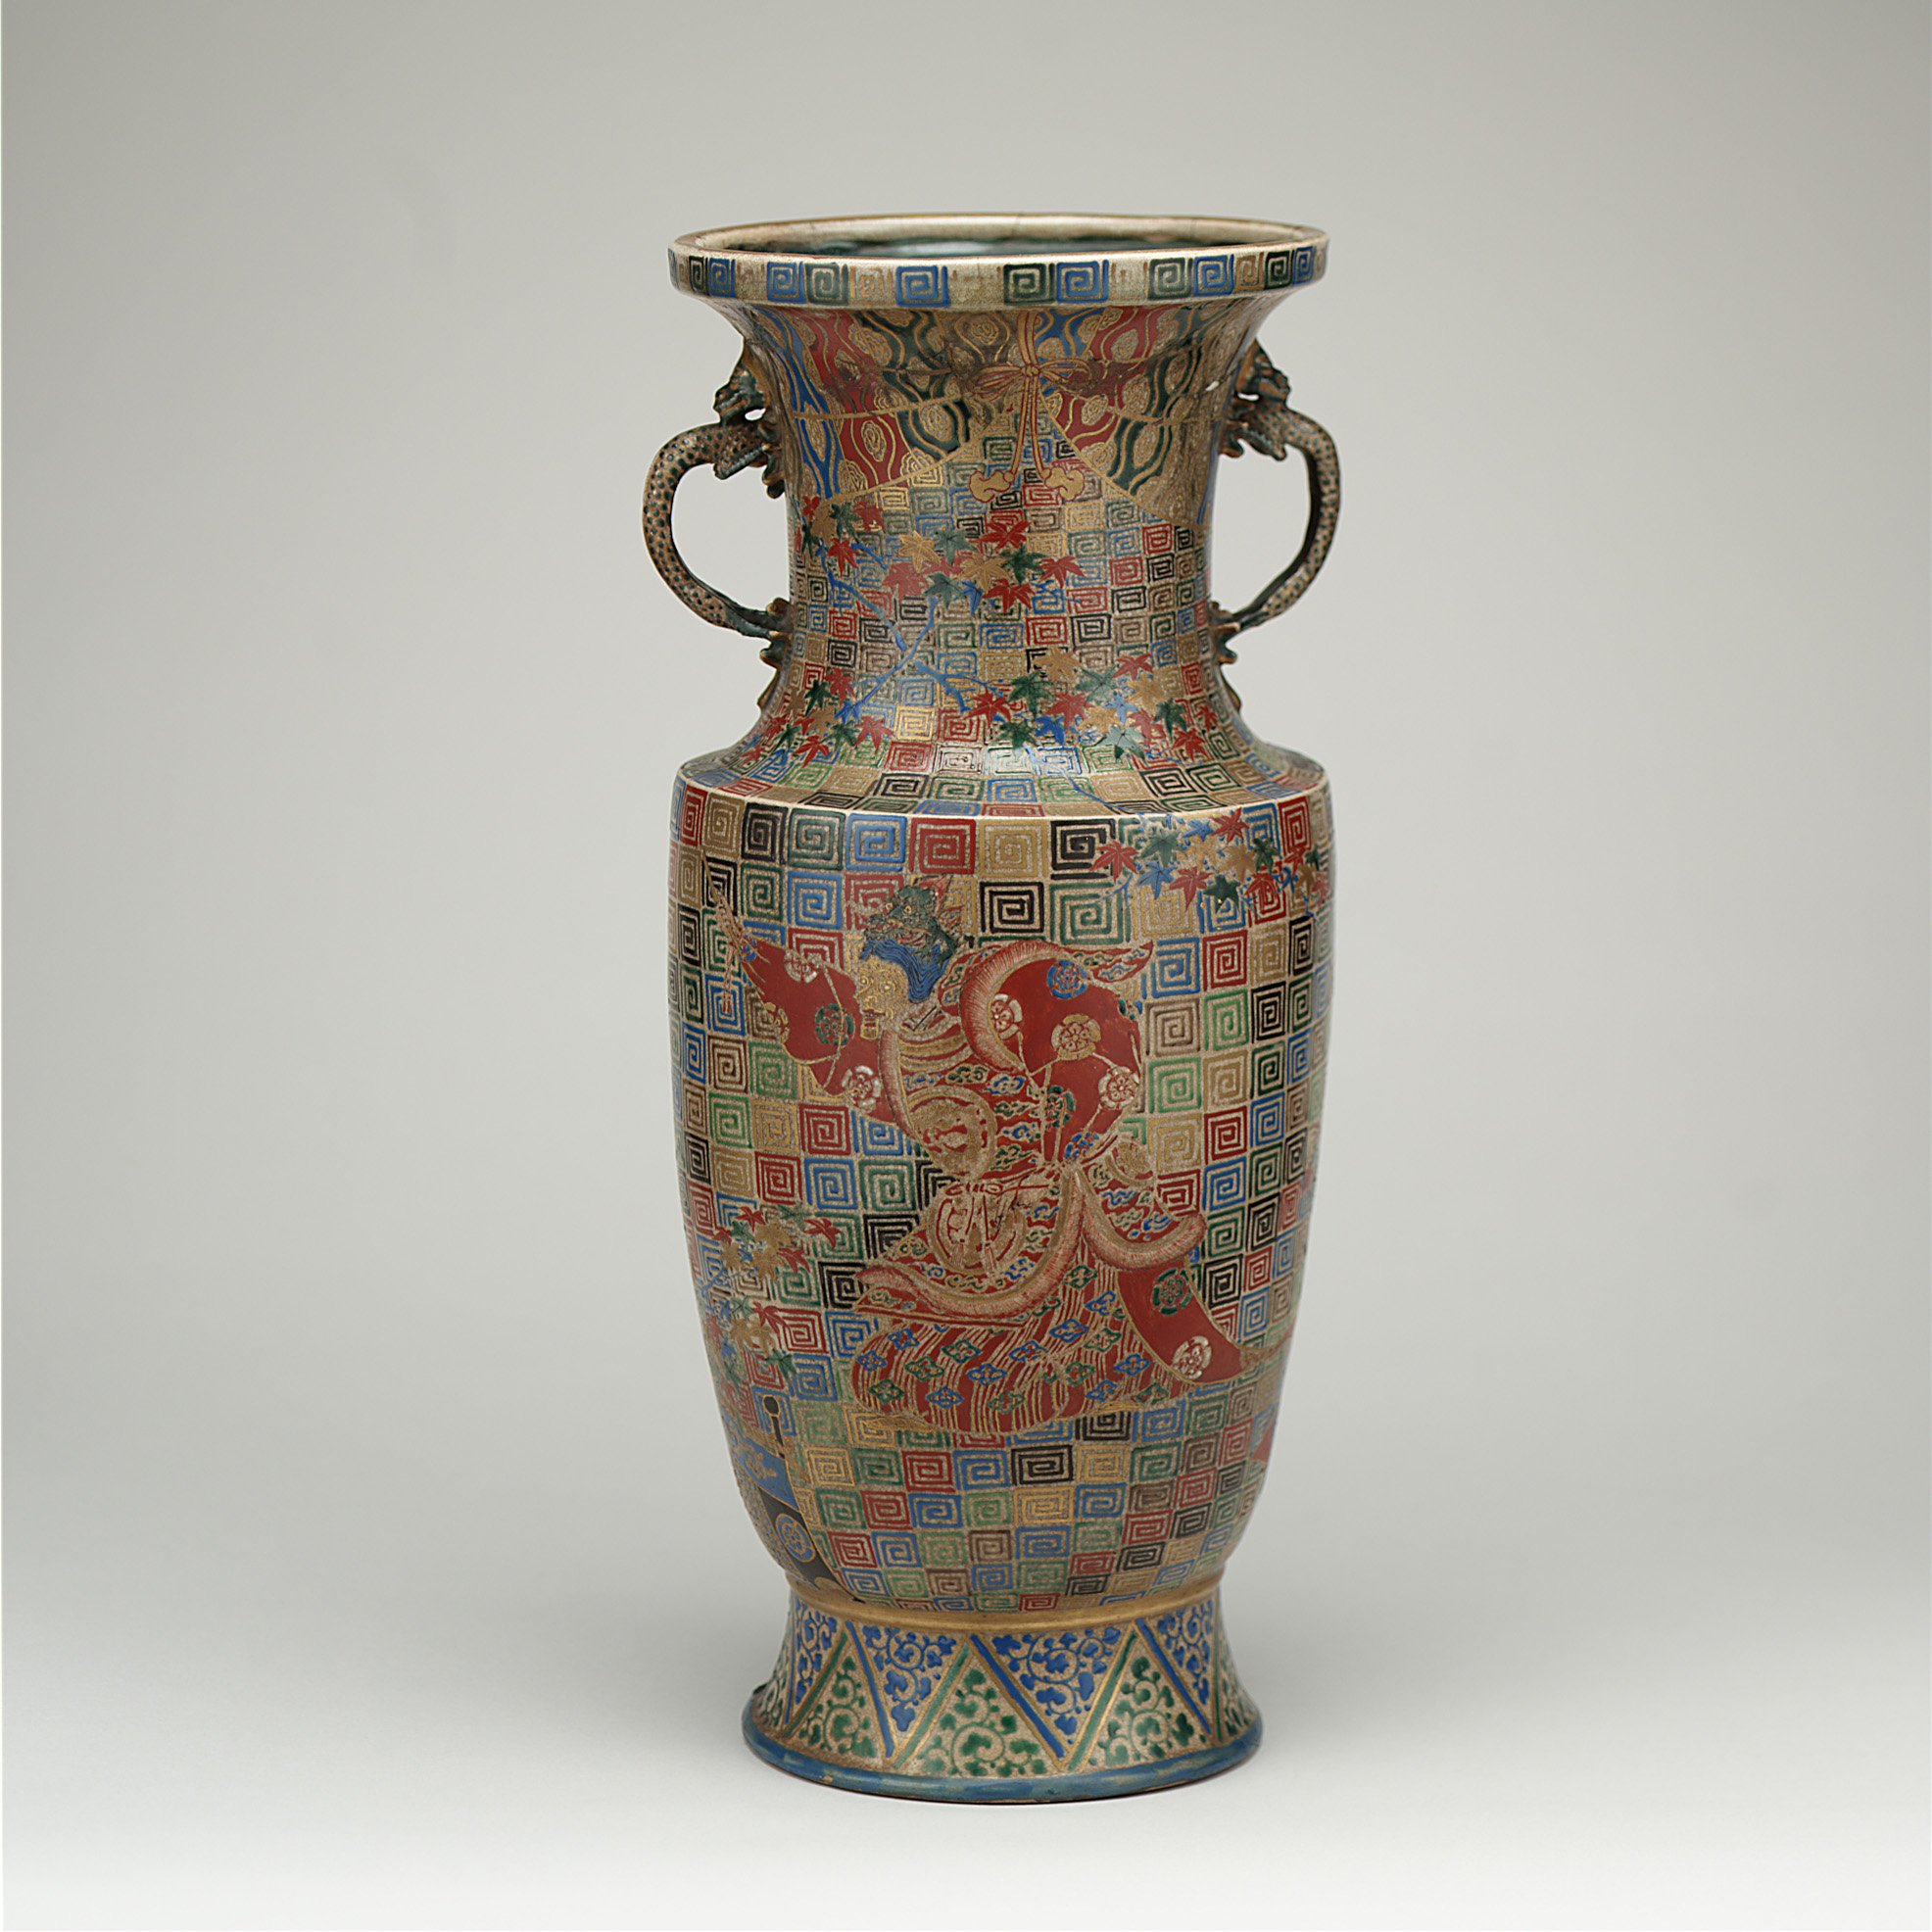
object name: vase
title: Vase with Depiction of Bugaku Dancer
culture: japanese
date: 1667-1700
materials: enamel, glaze, gold, pottery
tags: human figures,dancers